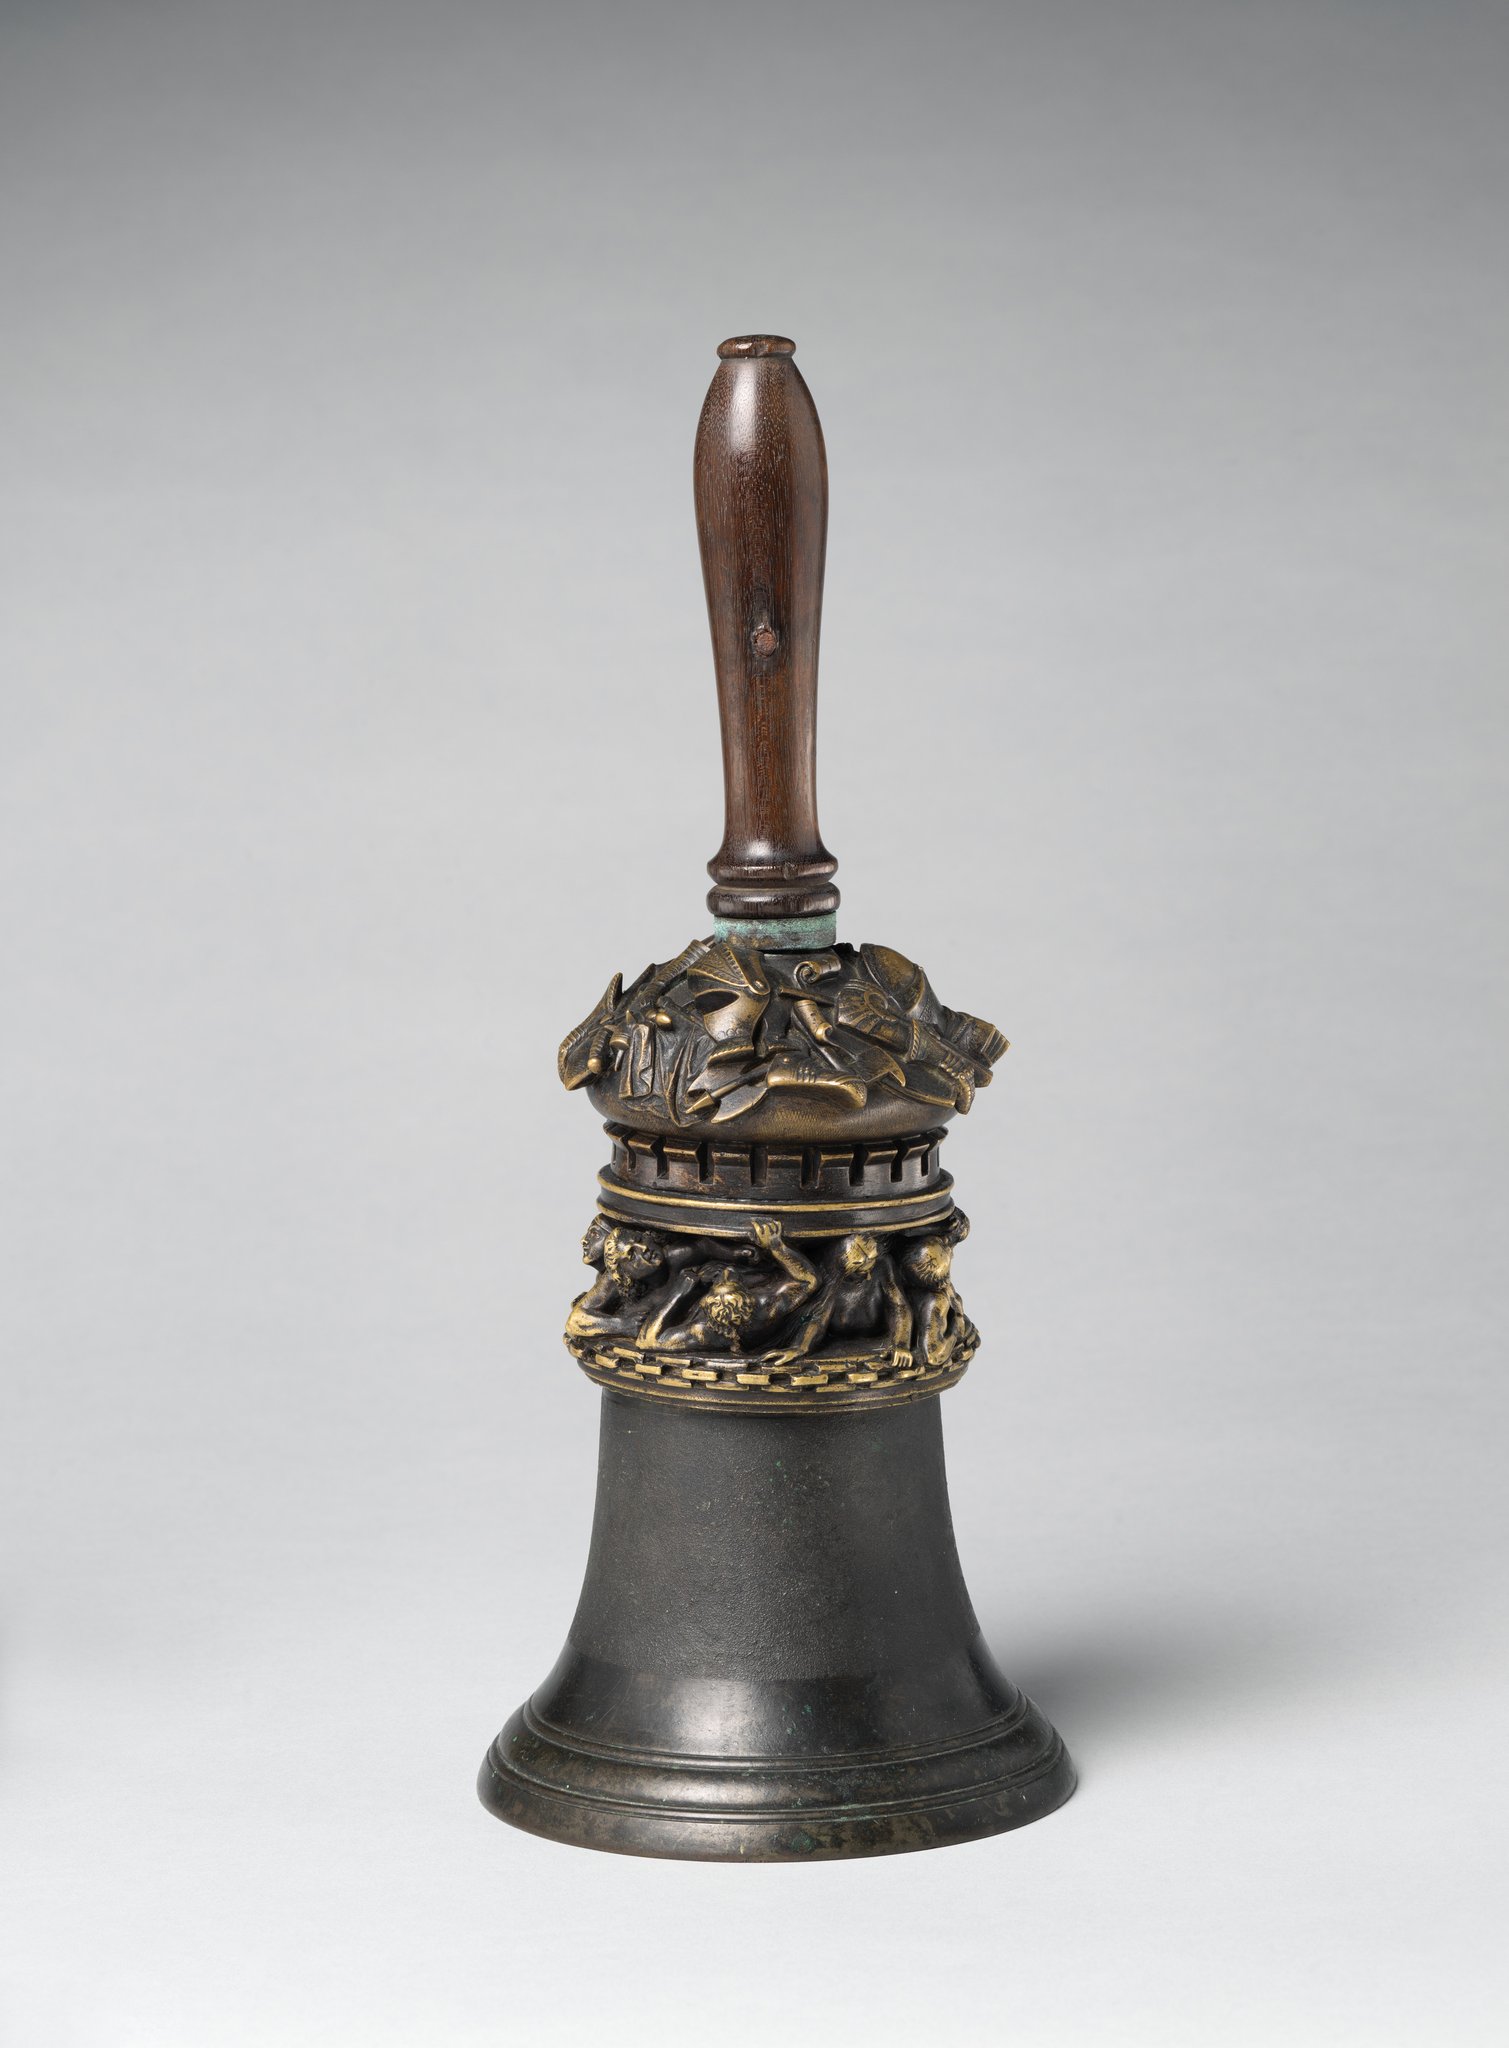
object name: handbell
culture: french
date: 1850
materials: bronze, iron, wood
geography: france